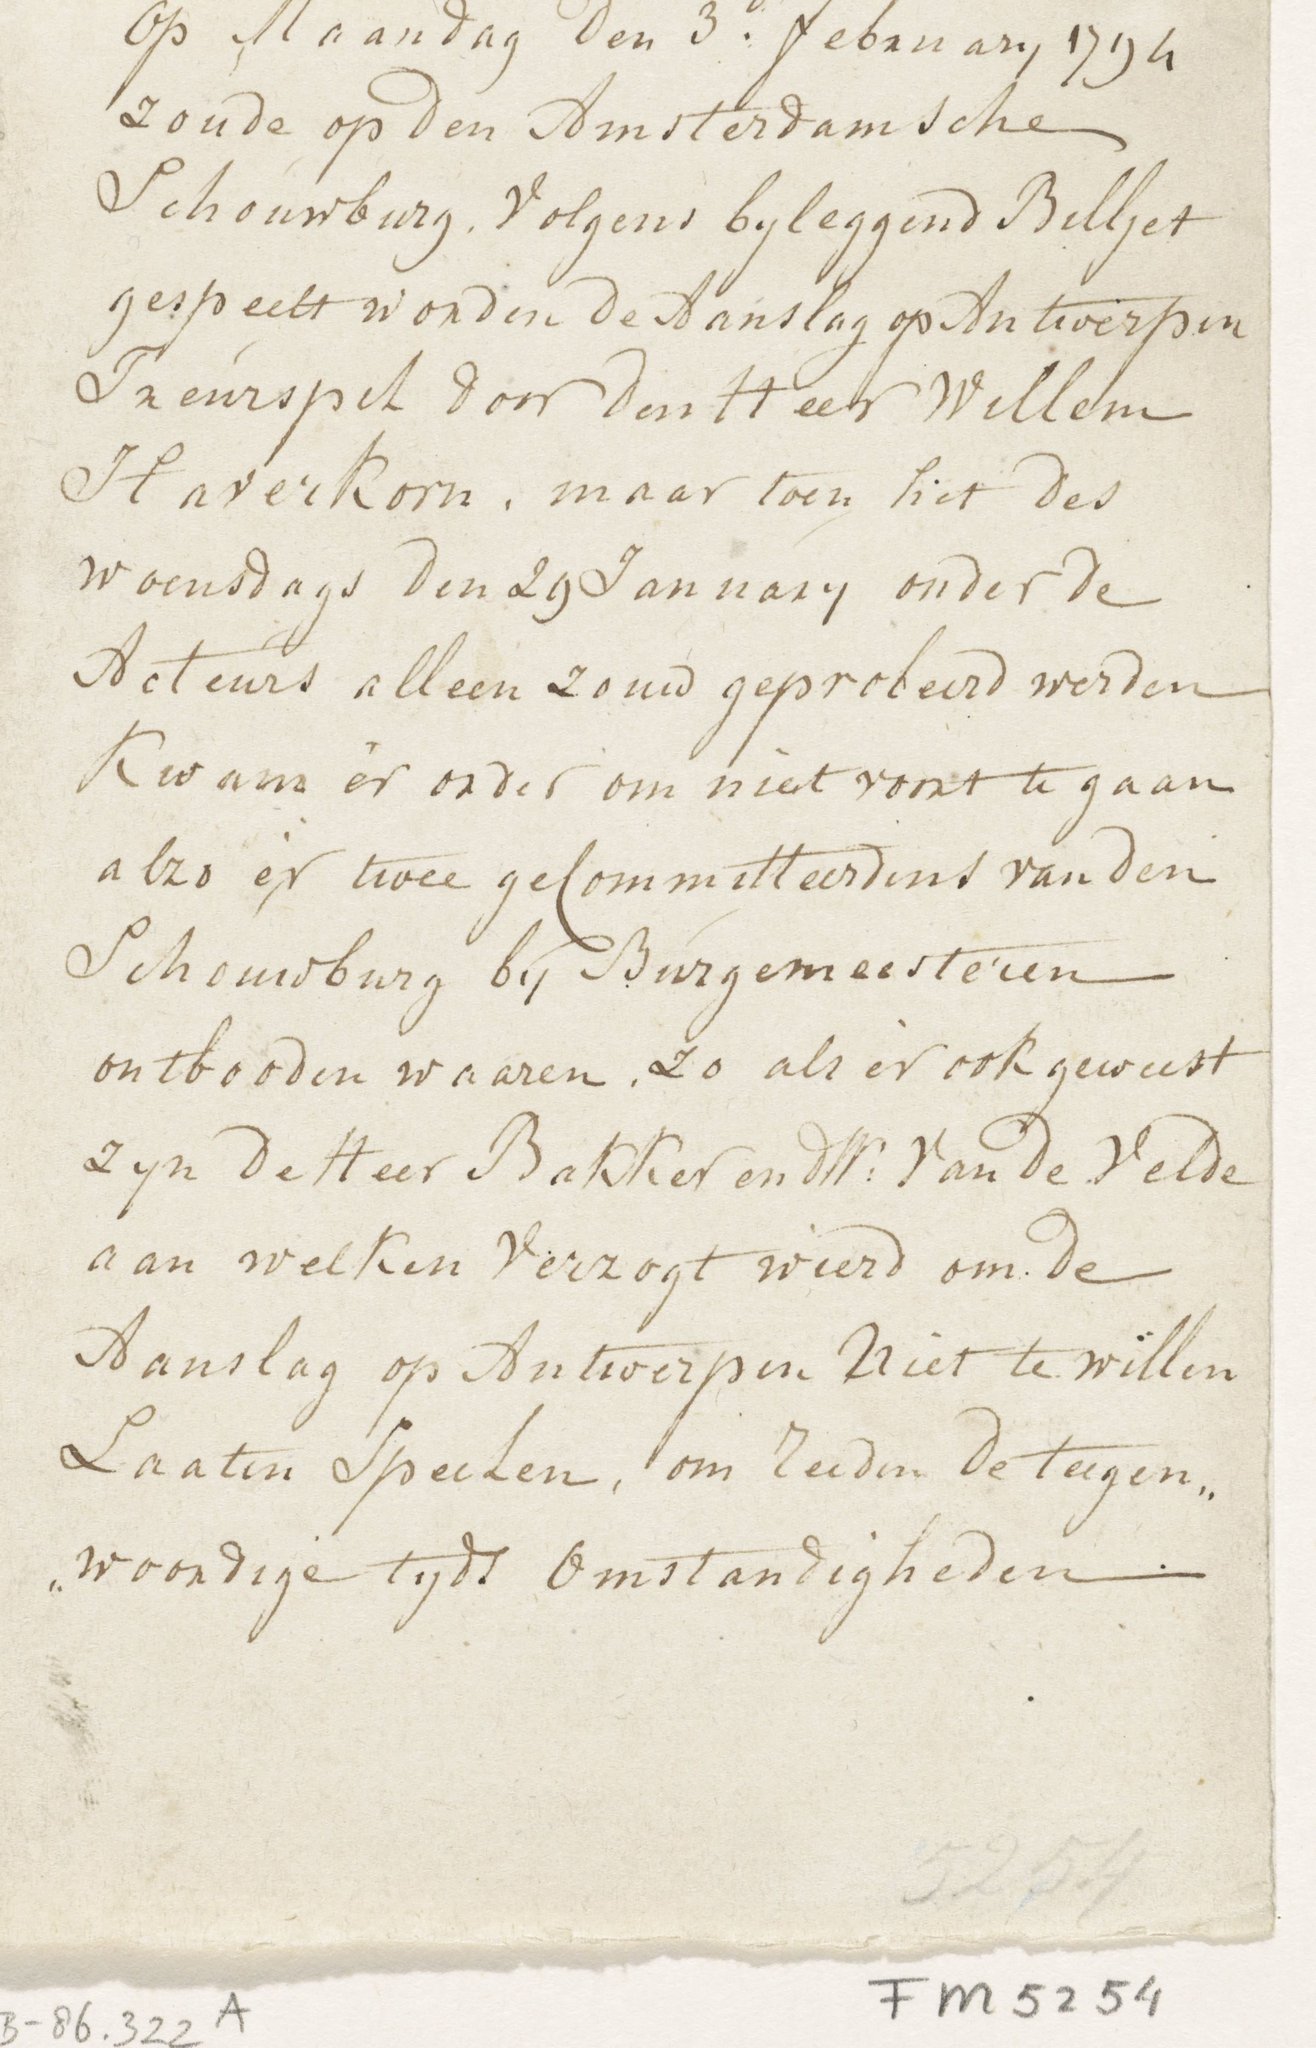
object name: text sheet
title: Handschrift over het niet doorgaan van de opvoering van het stuk 'De Aanslag op Antwerpen', 1794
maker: Anonymous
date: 1794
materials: paper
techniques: writing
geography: northern netherlands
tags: antwerp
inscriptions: collector's mark: Lugt 2228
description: Blad met een handschrift over het niet doorgaan van de opvoering van het toneelstuk 'De Aanslag op Antwerpen' door Willem Haverkorn, op 3 februari 1794 in de Schouwburg te Amsterdam, wegens 'de tegenwoordige tijds omstandigheden'.